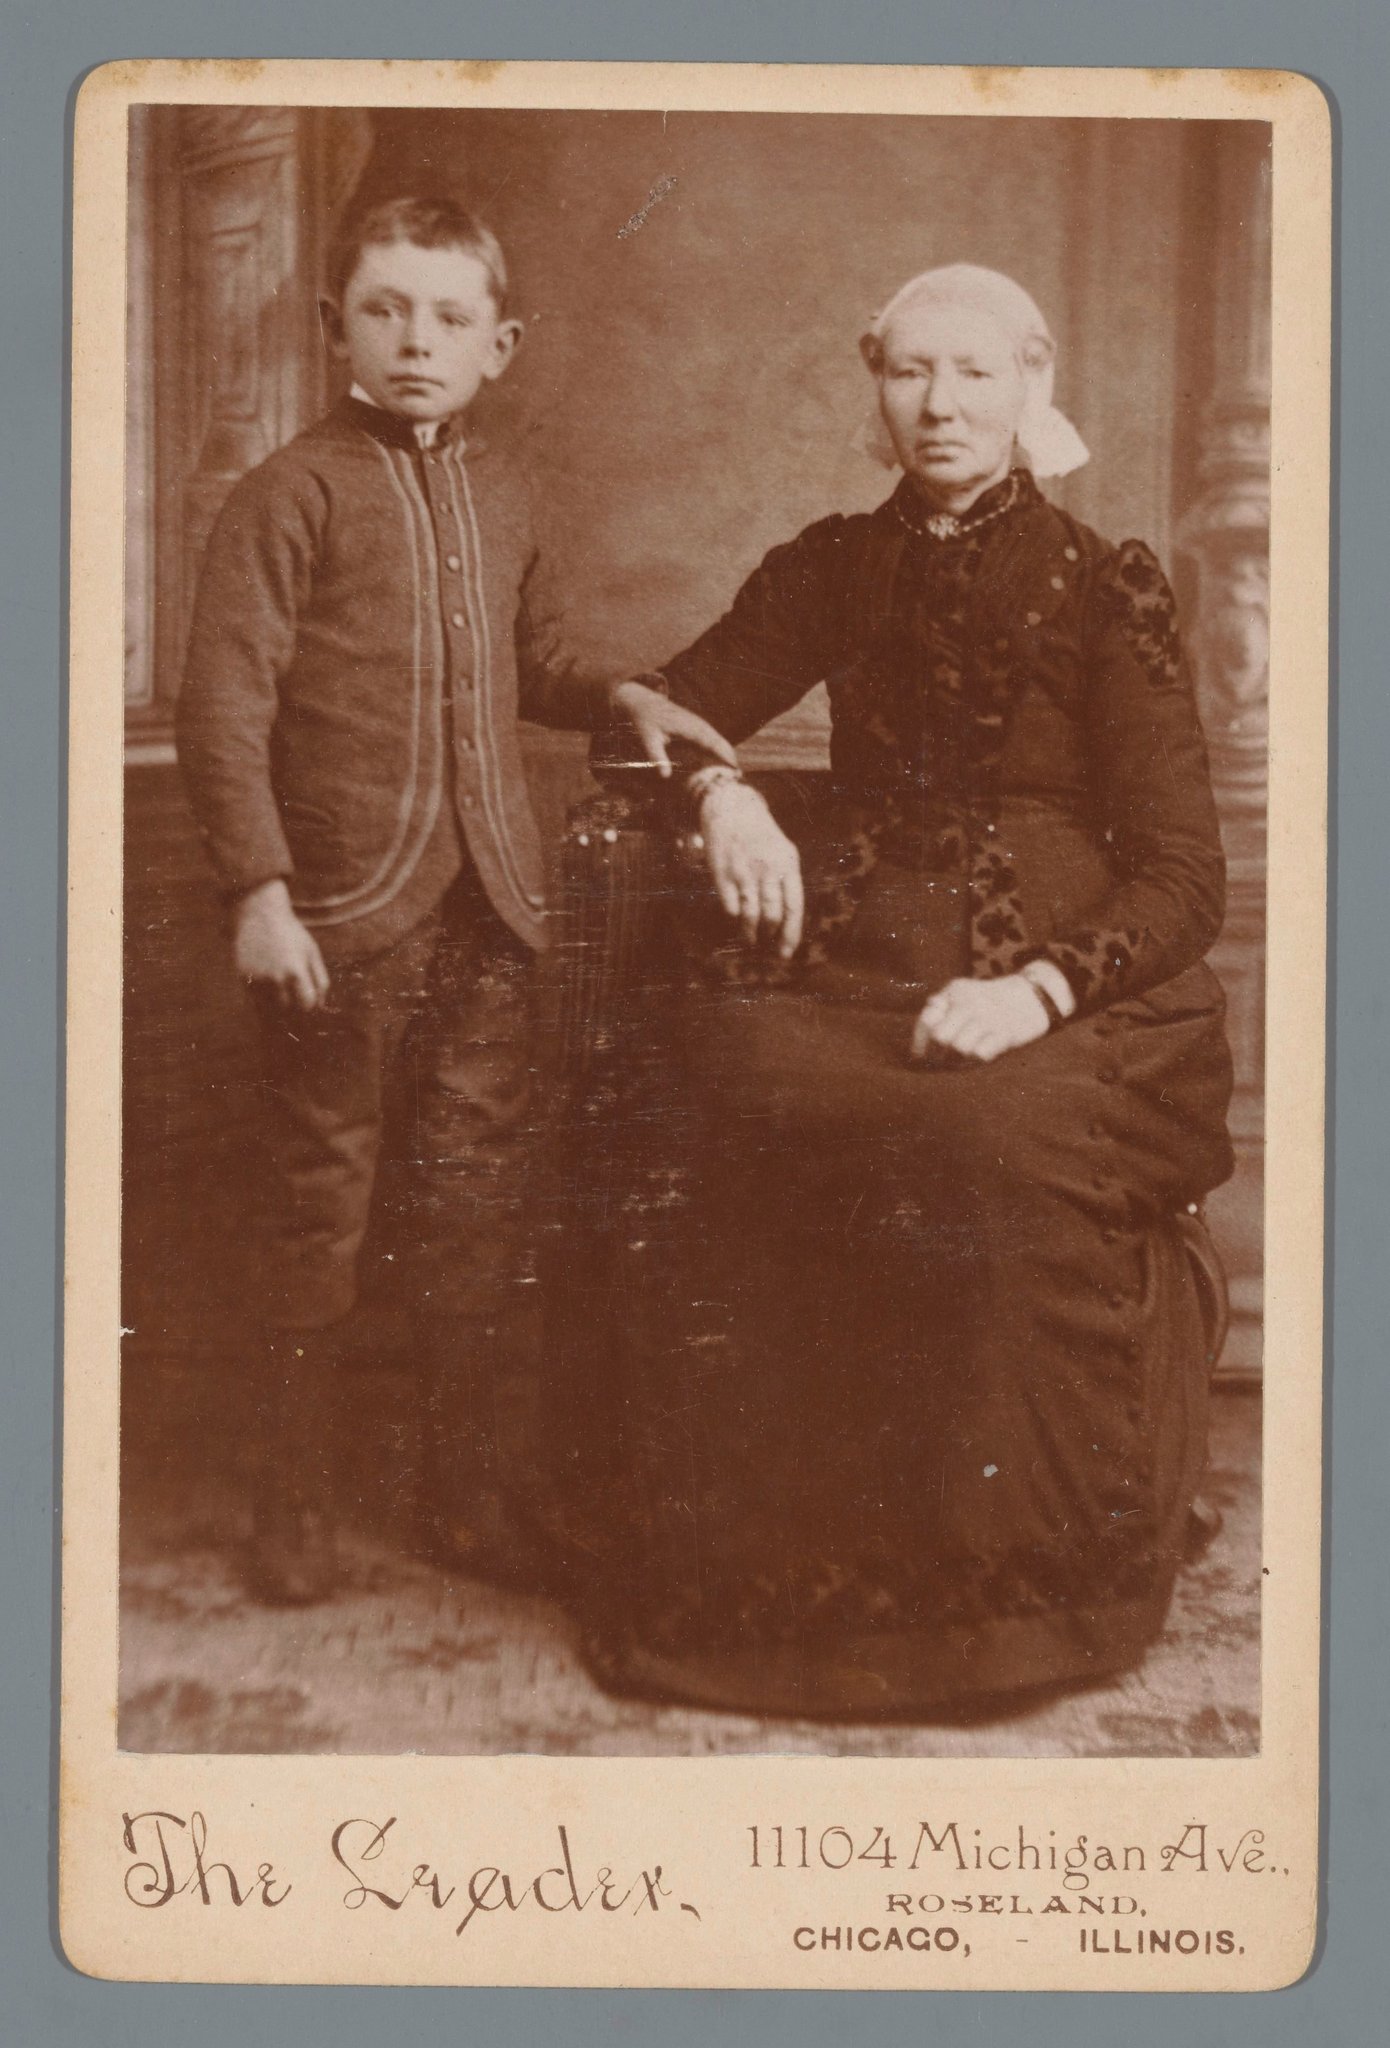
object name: cabinet photograph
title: Portret van Aafke Postma in Friese klederdracht met haar jongste zoontje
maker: the leader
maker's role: fotograaf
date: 1880-1900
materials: cardboard, photographic support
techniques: collodion silver print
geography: chicago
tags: studio requisites ~ photographer, head-gear: cap, folk costume, regional costume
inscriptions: name: ‘Aafke Postma en jongste zoontje.’